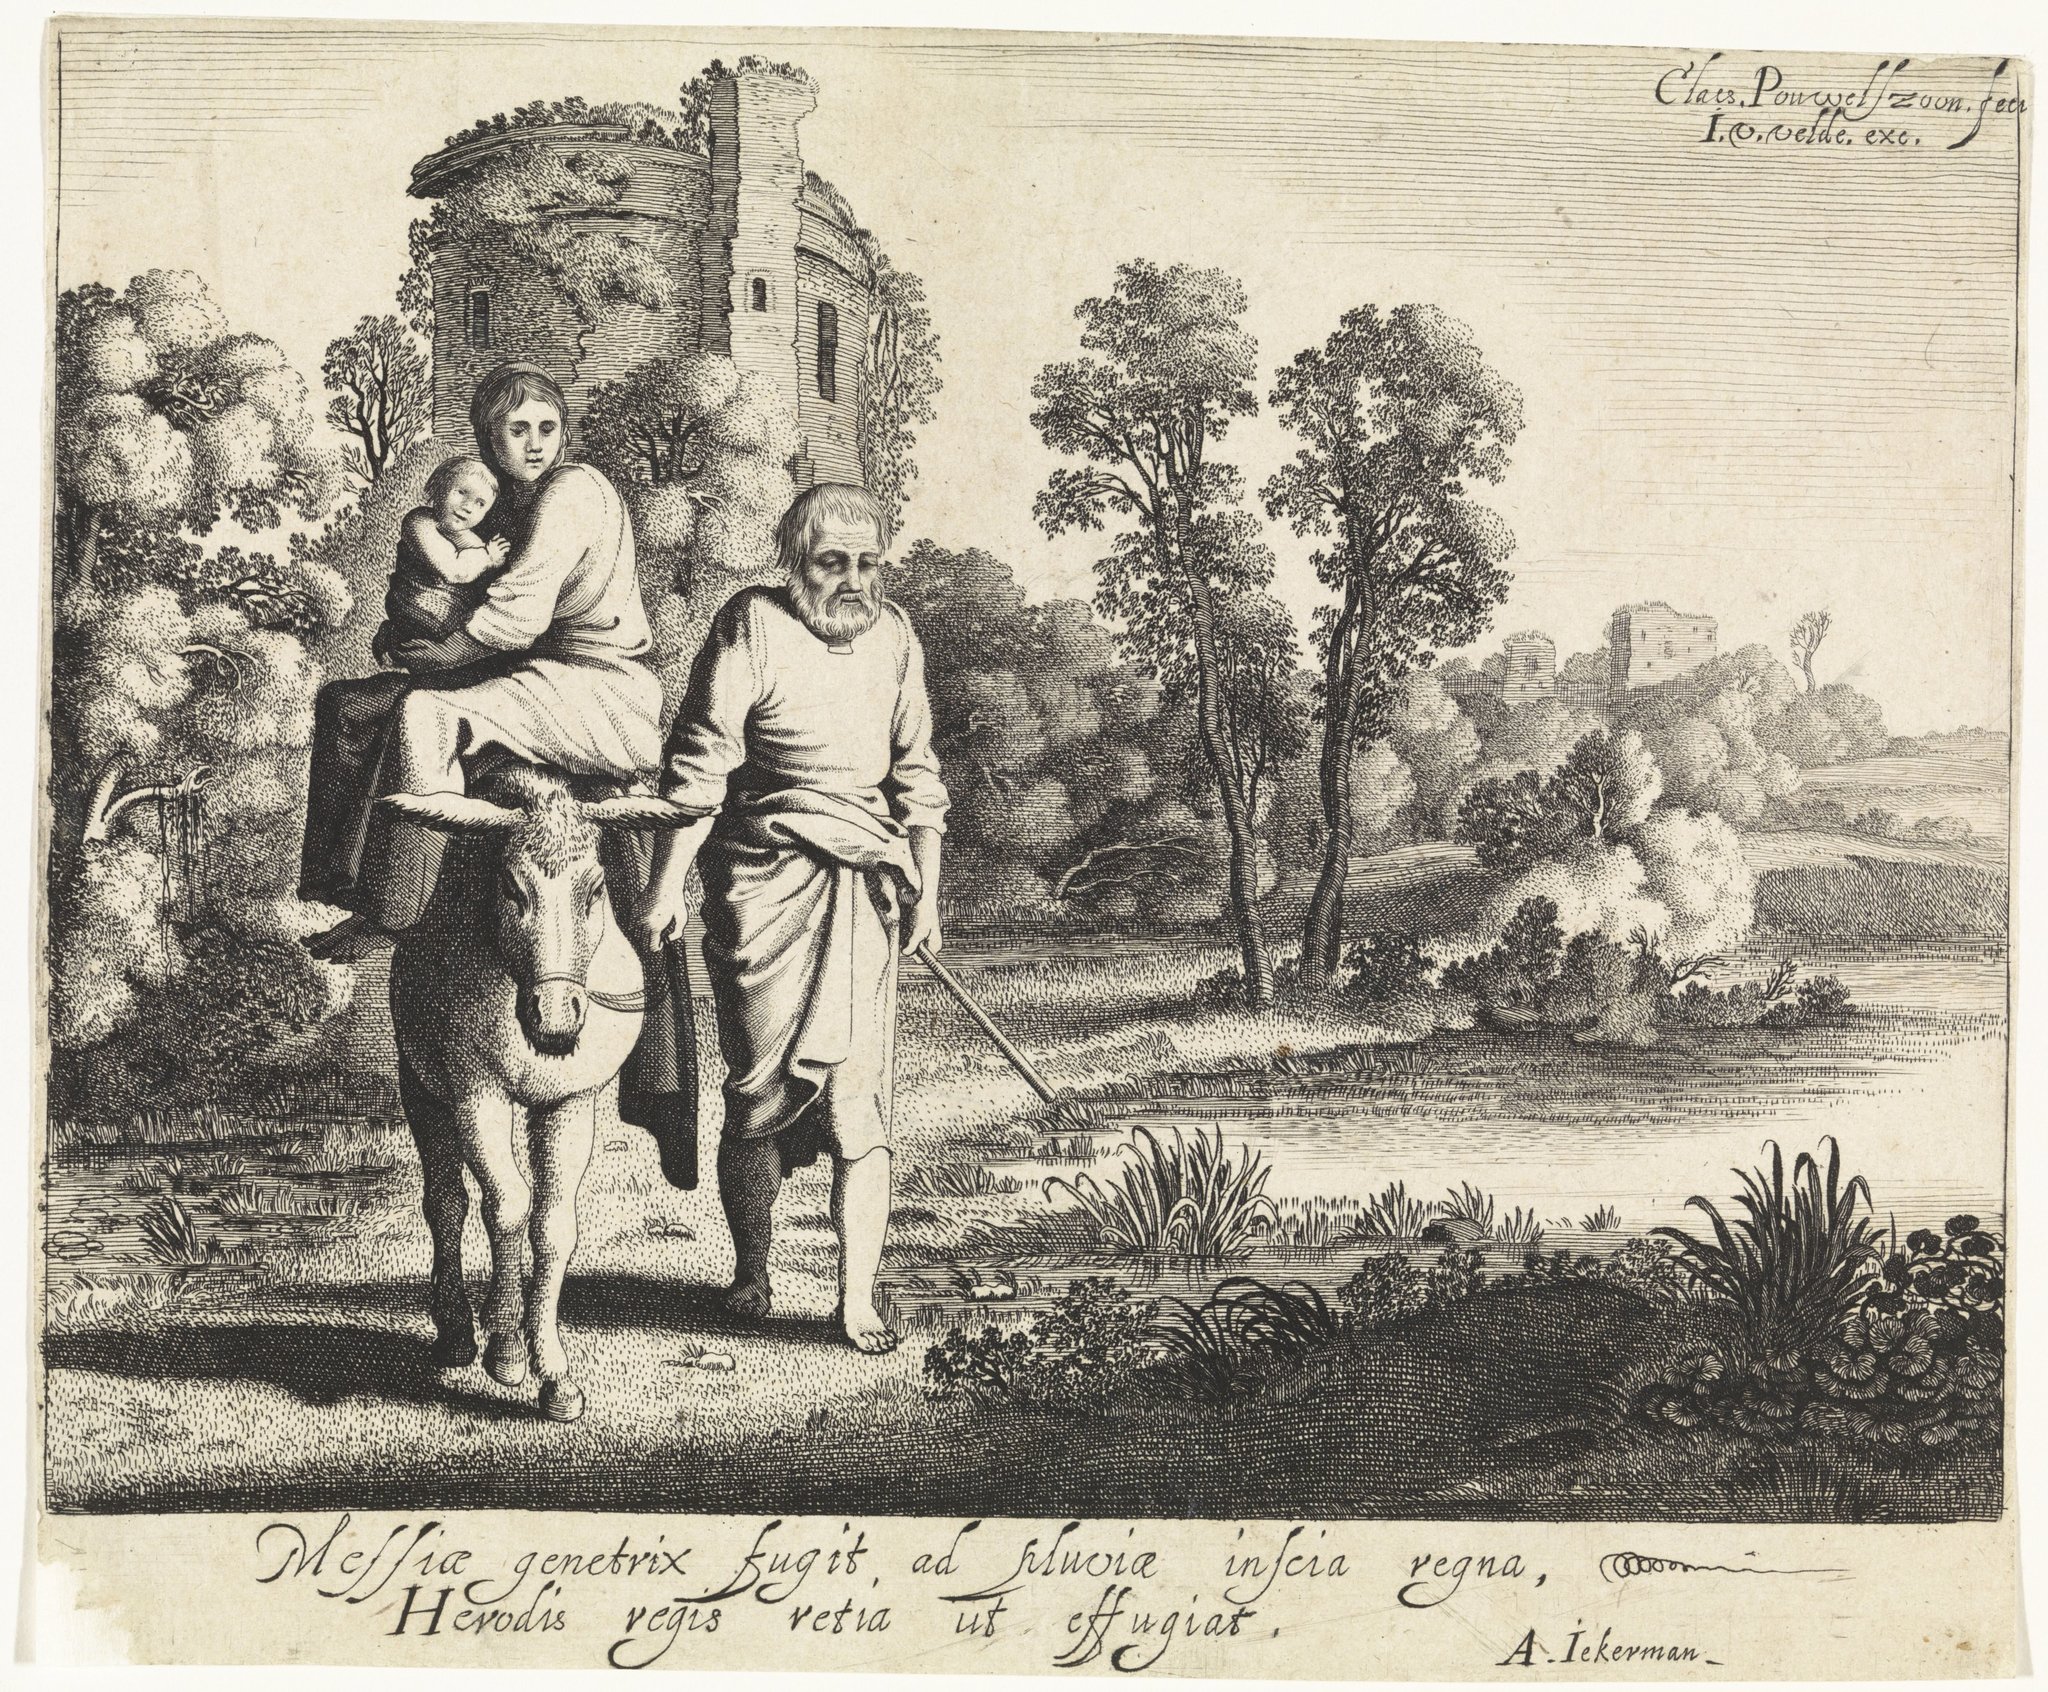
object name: print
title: Landschap met de vlucht naar Egypte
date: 1615-1641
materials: paper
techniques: engraving, etching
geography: northern netherlands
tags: the flight into egypt: mary, joseph, the child (and sometimes others) on their way; mary usually riding on an ass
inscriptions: collector's mark: Lugt 2228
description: In een landschap met ruïnes leidt Jozef de ezel met daarop Maria die het Christuskind in haar armen houdt. In de marge twee dichtregels in het Latijn.